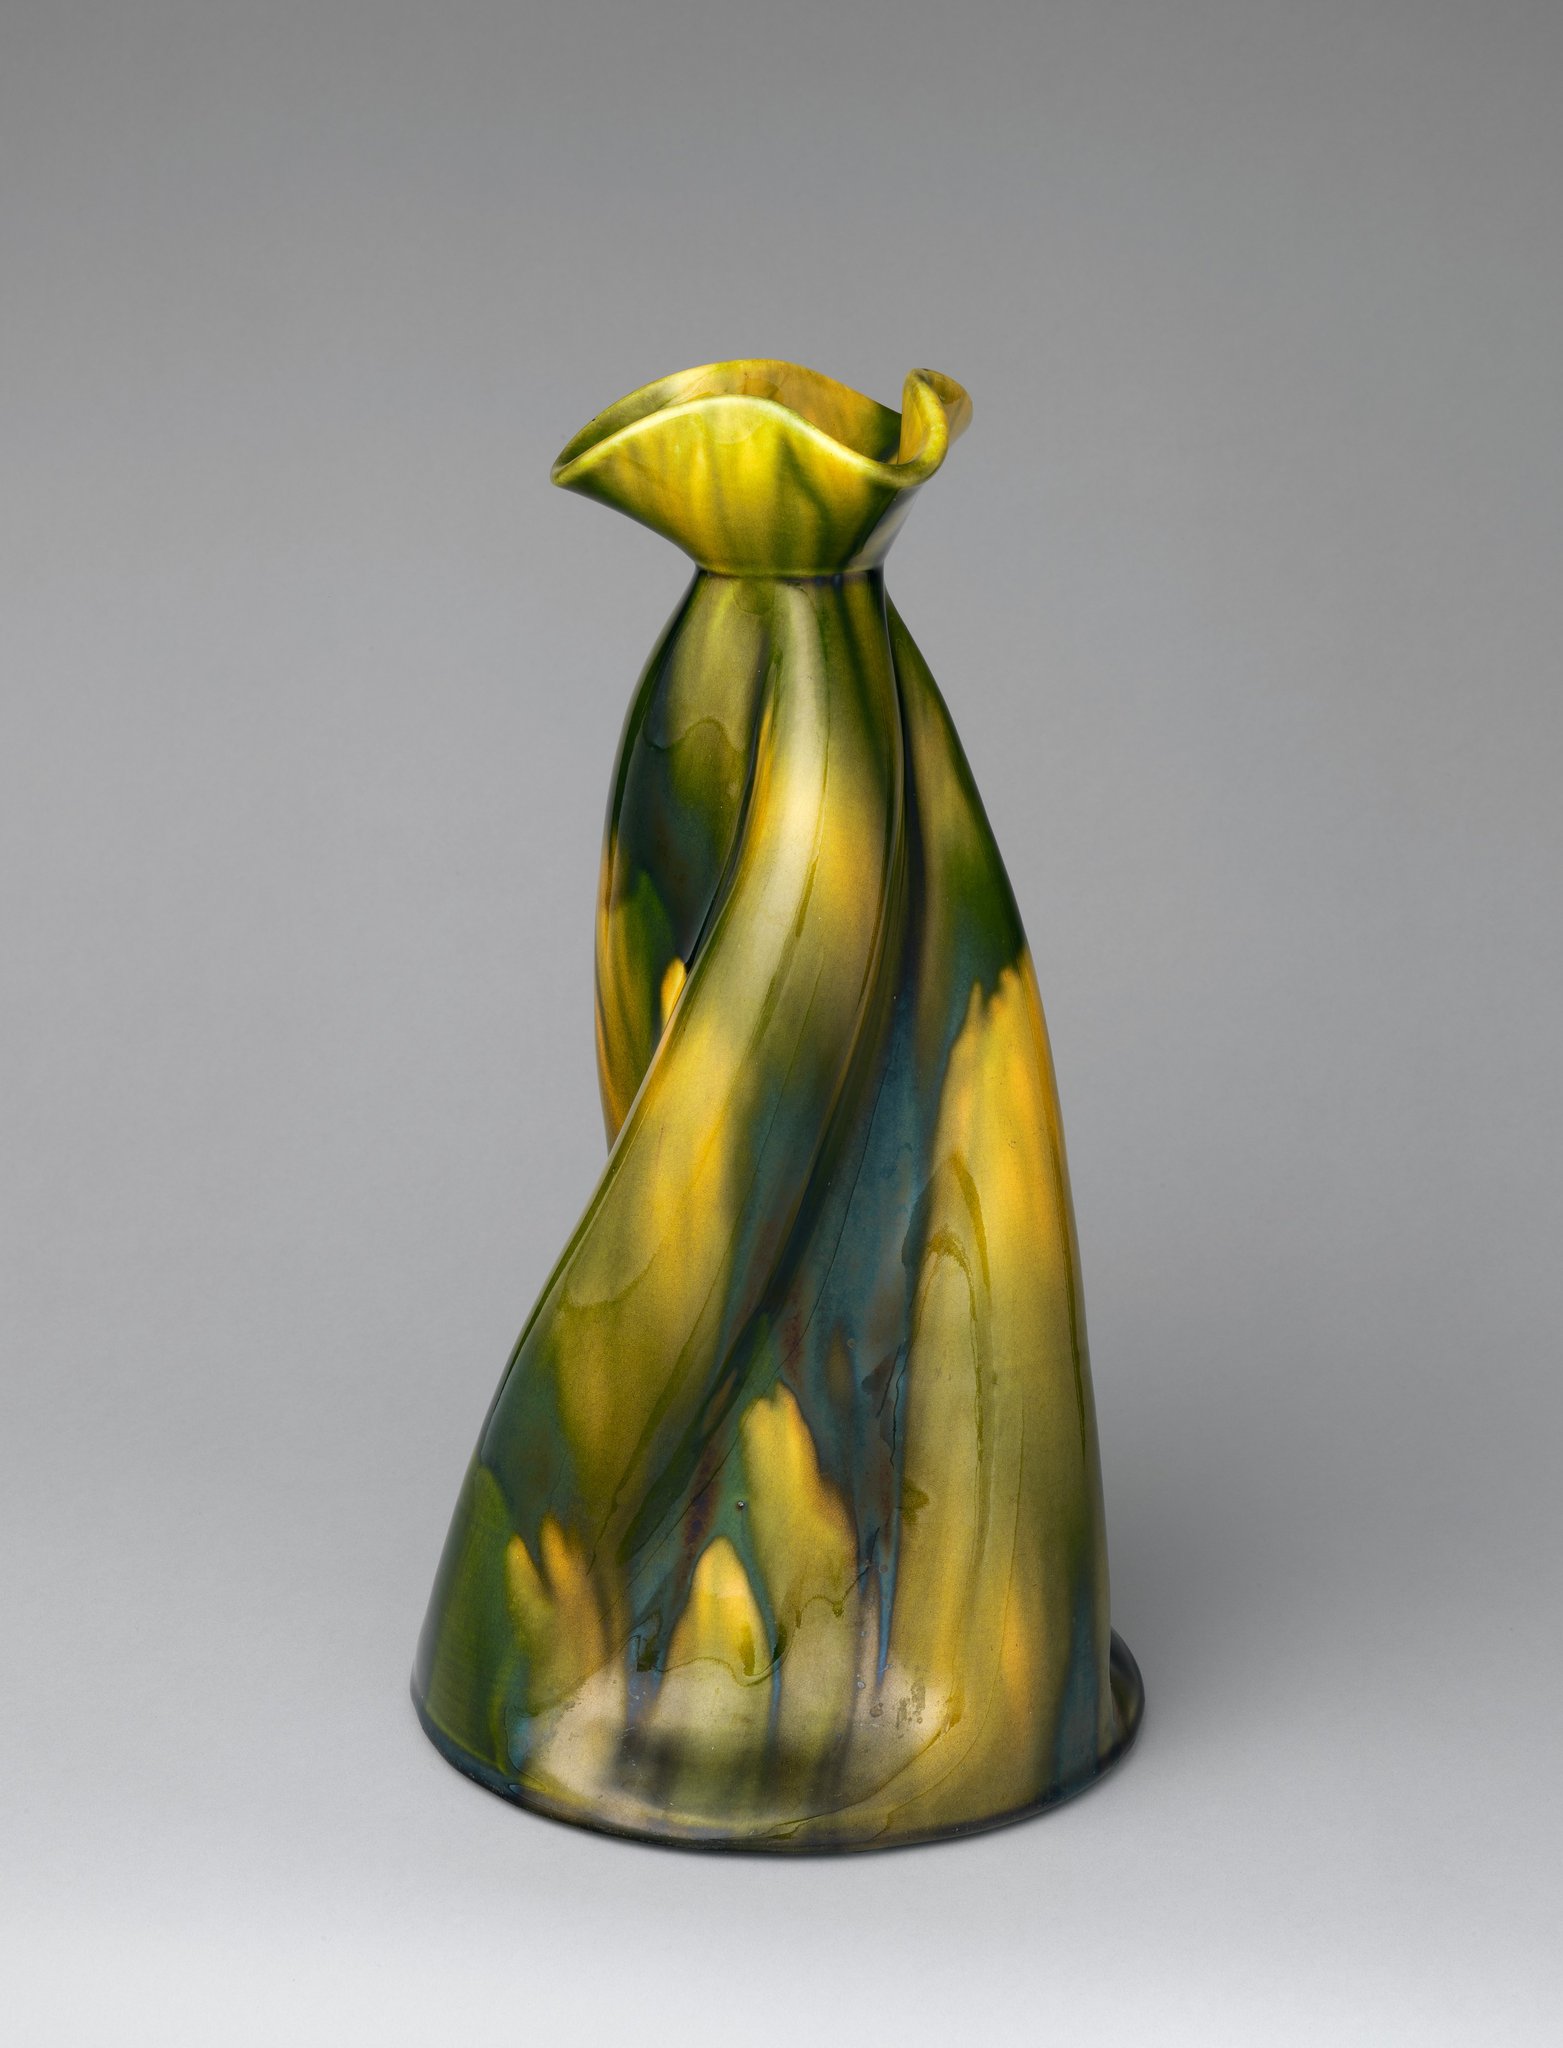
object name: vase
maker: christopher dresser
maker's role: designer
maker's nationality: british, scottish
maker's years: 1834-1904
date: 1893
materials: earthenware